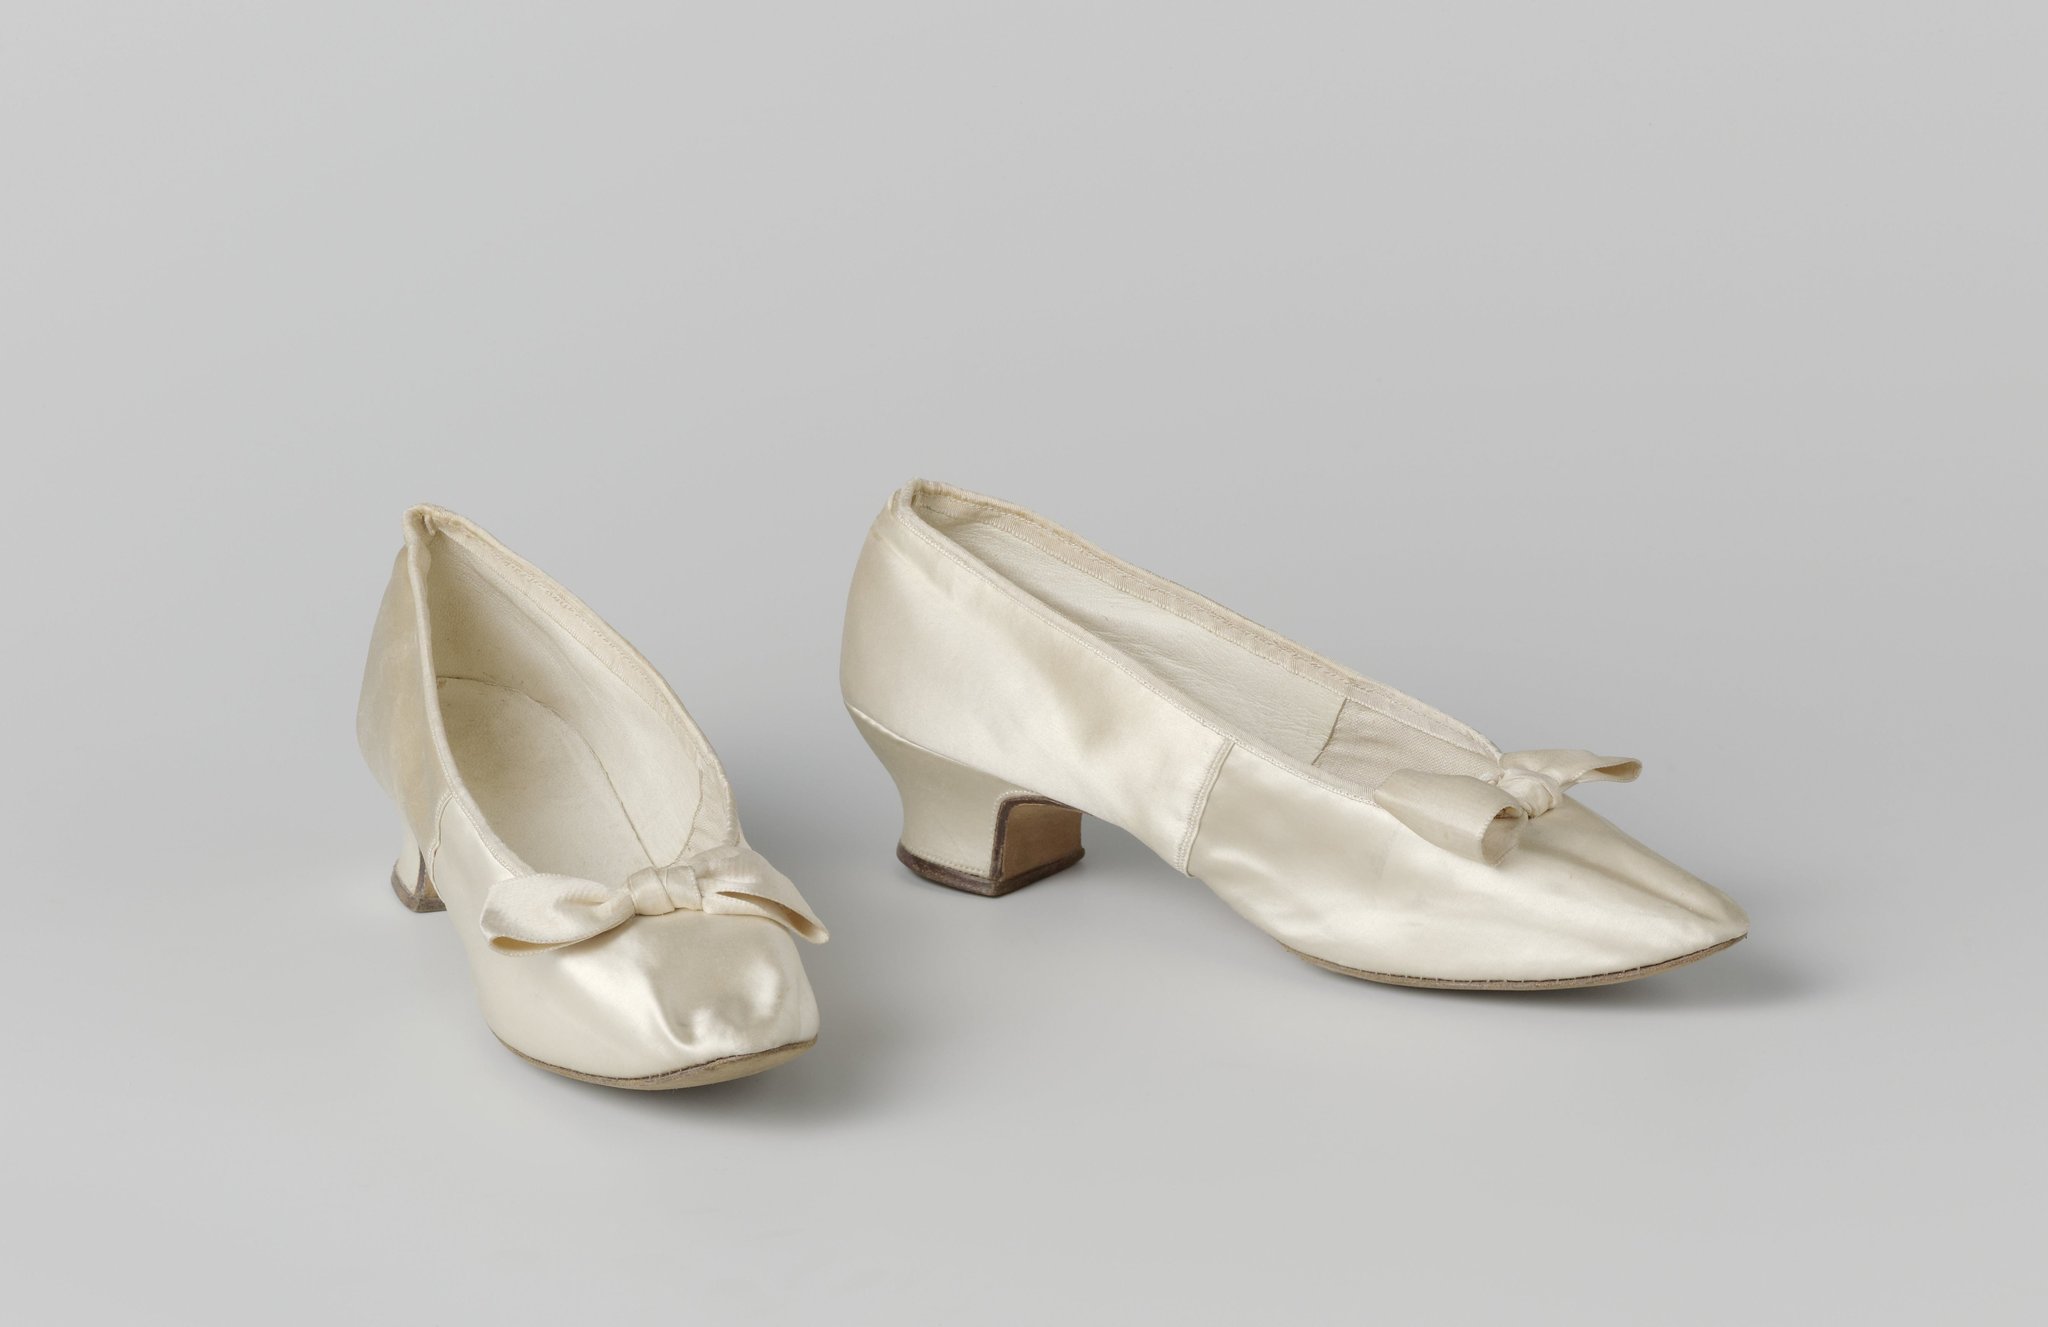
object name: womenswear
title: Bruidsschoen van roomwitte satijn met strikken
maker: Anonymous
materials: leather, metal, textile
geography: england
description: Bruidsschoen van roomwit satijn, met dito strikken. Pump met spitse neus. Uit één voorblad en één achterblad. Op de zool een adres in blinddruk (niet goed leesbaar): MANFIELD (?). Gevoerd met glacéleer. Bij de instap een strik van satijn.